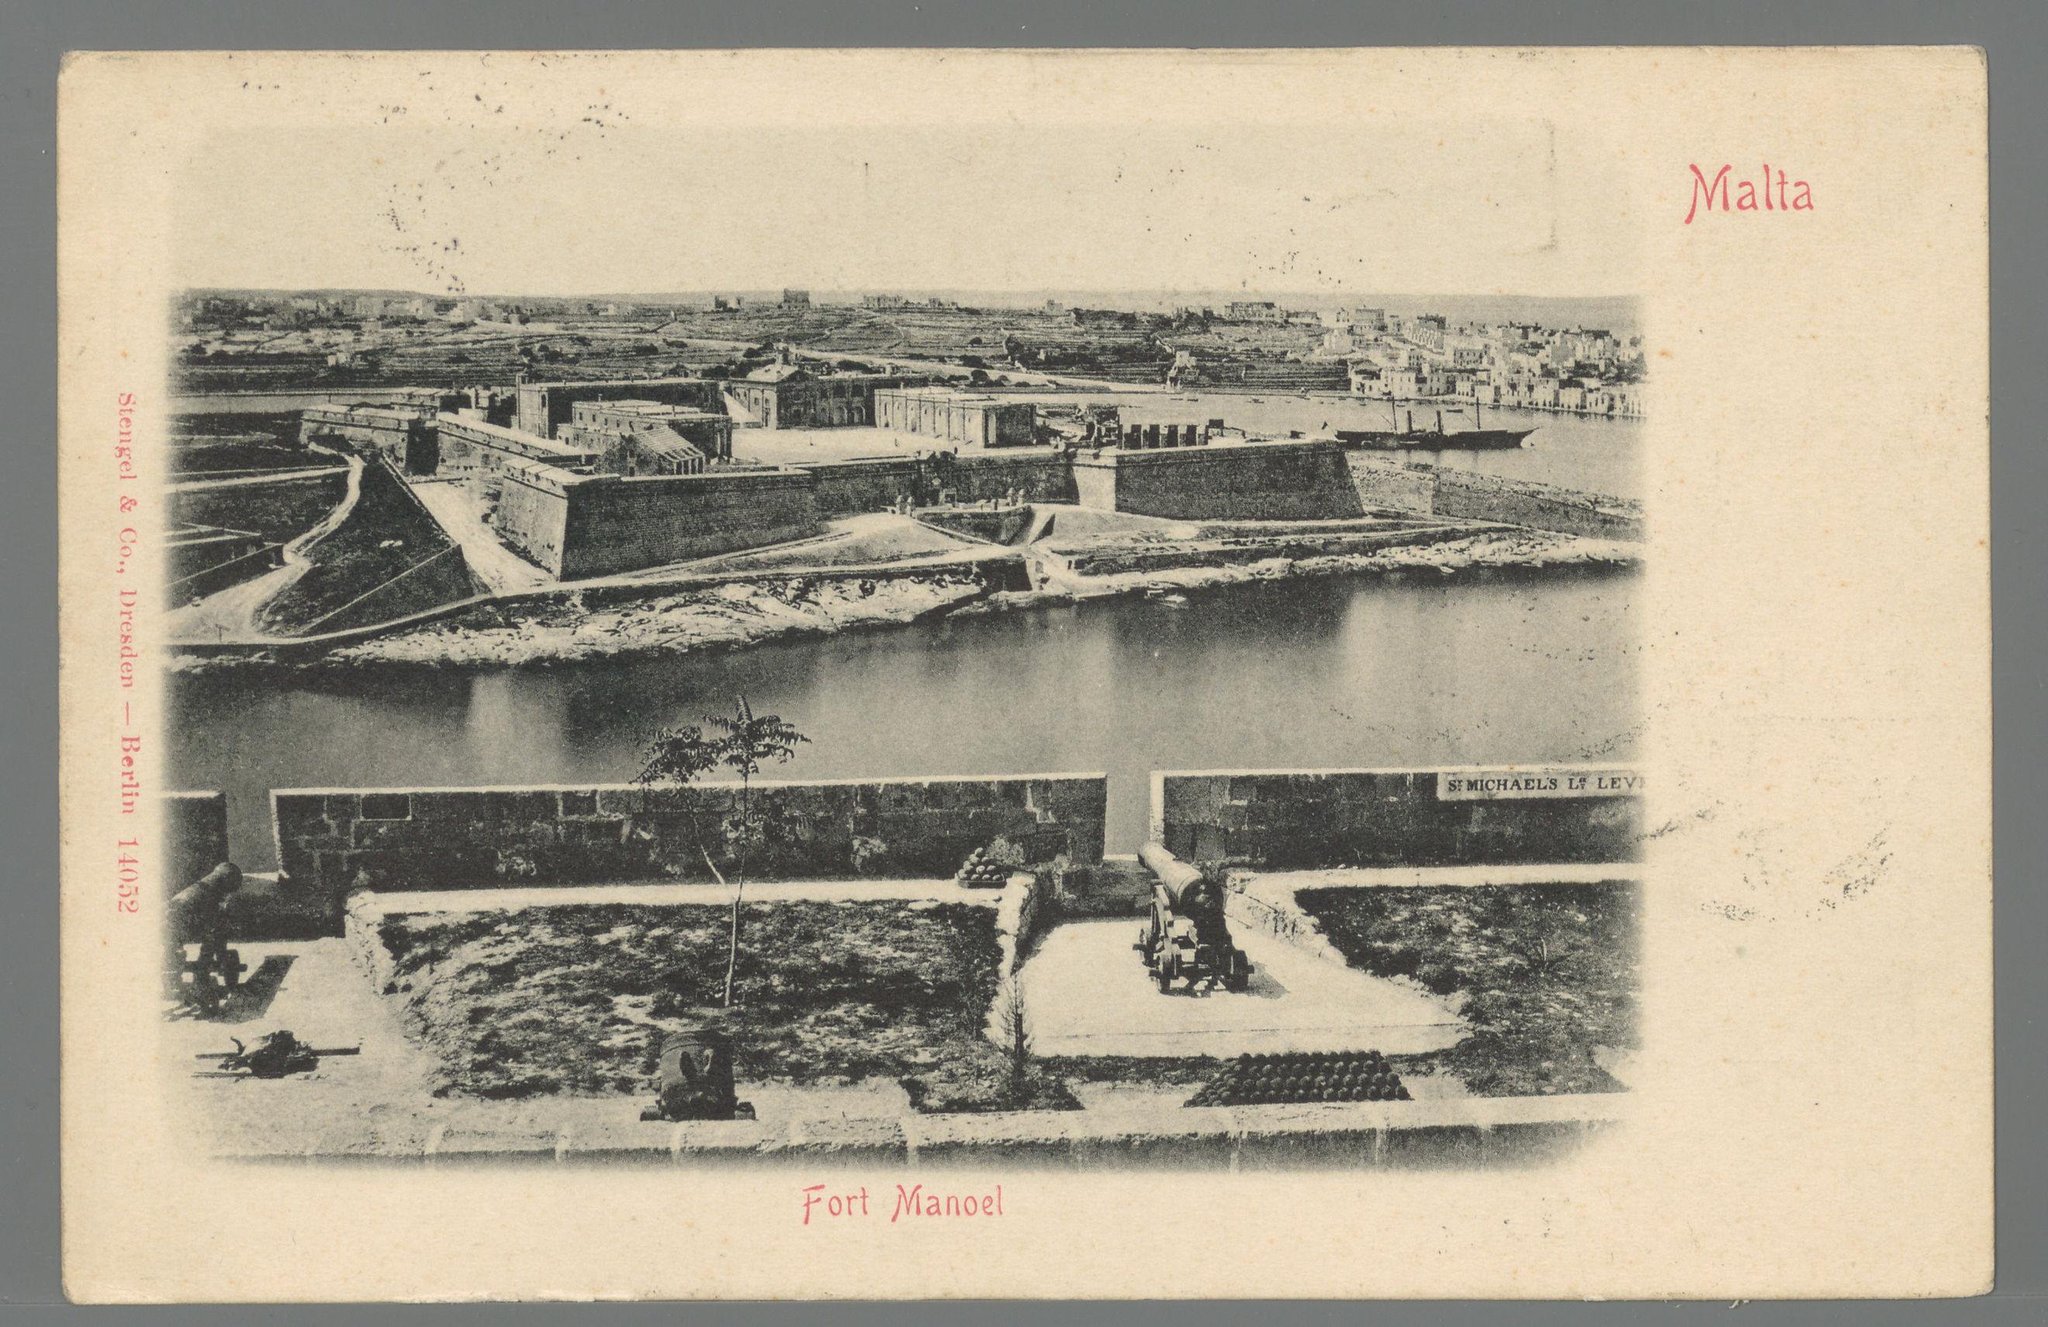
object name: ansichtkaart, prentbriefkaart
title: Malta. Fort Manoel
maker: Anonymous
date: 1889-1903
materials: cardboard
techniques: photograph, writing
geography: malta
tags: fortress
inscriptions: poststempel, verso, gestempeld